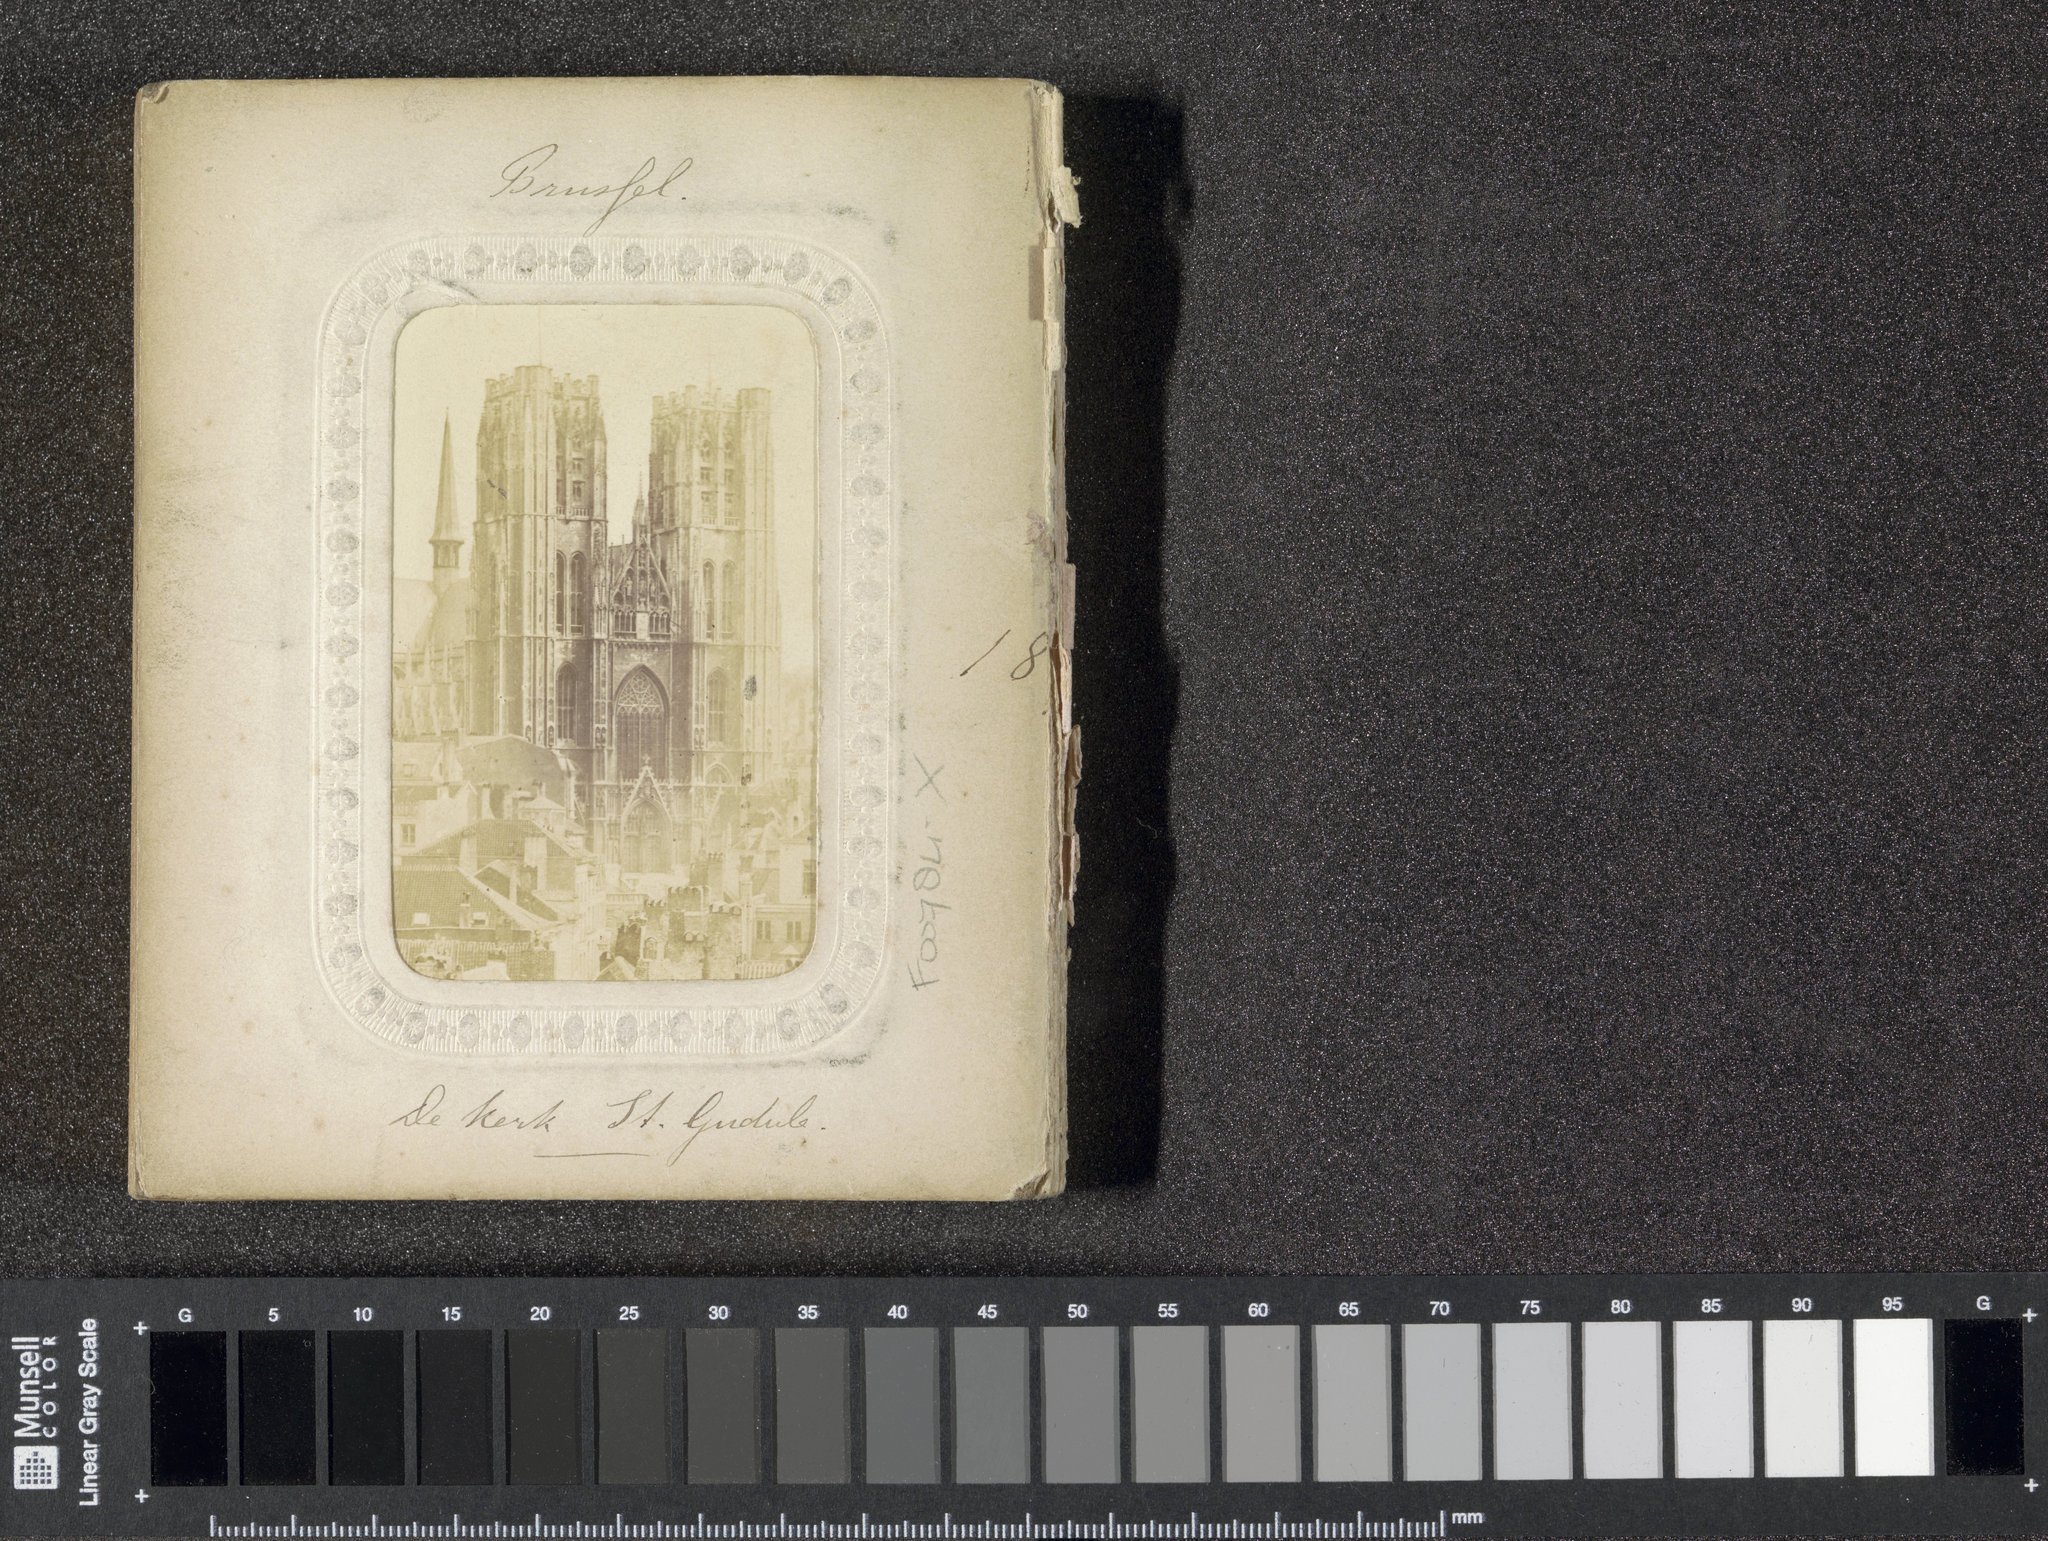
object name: photograph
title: Brussel. De kerk st. Gudule.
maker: Anonymous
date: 1868-1872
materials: cardboard, paper, photographic support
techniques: albumen print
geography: brussels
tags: parts of church exterior and annexes: tower, brussels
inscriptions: name: ‘EdV’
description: Onderdeel van Fotoalbum met bezienswaardigheden in Nederlandse, Belgische en Duitse steden.